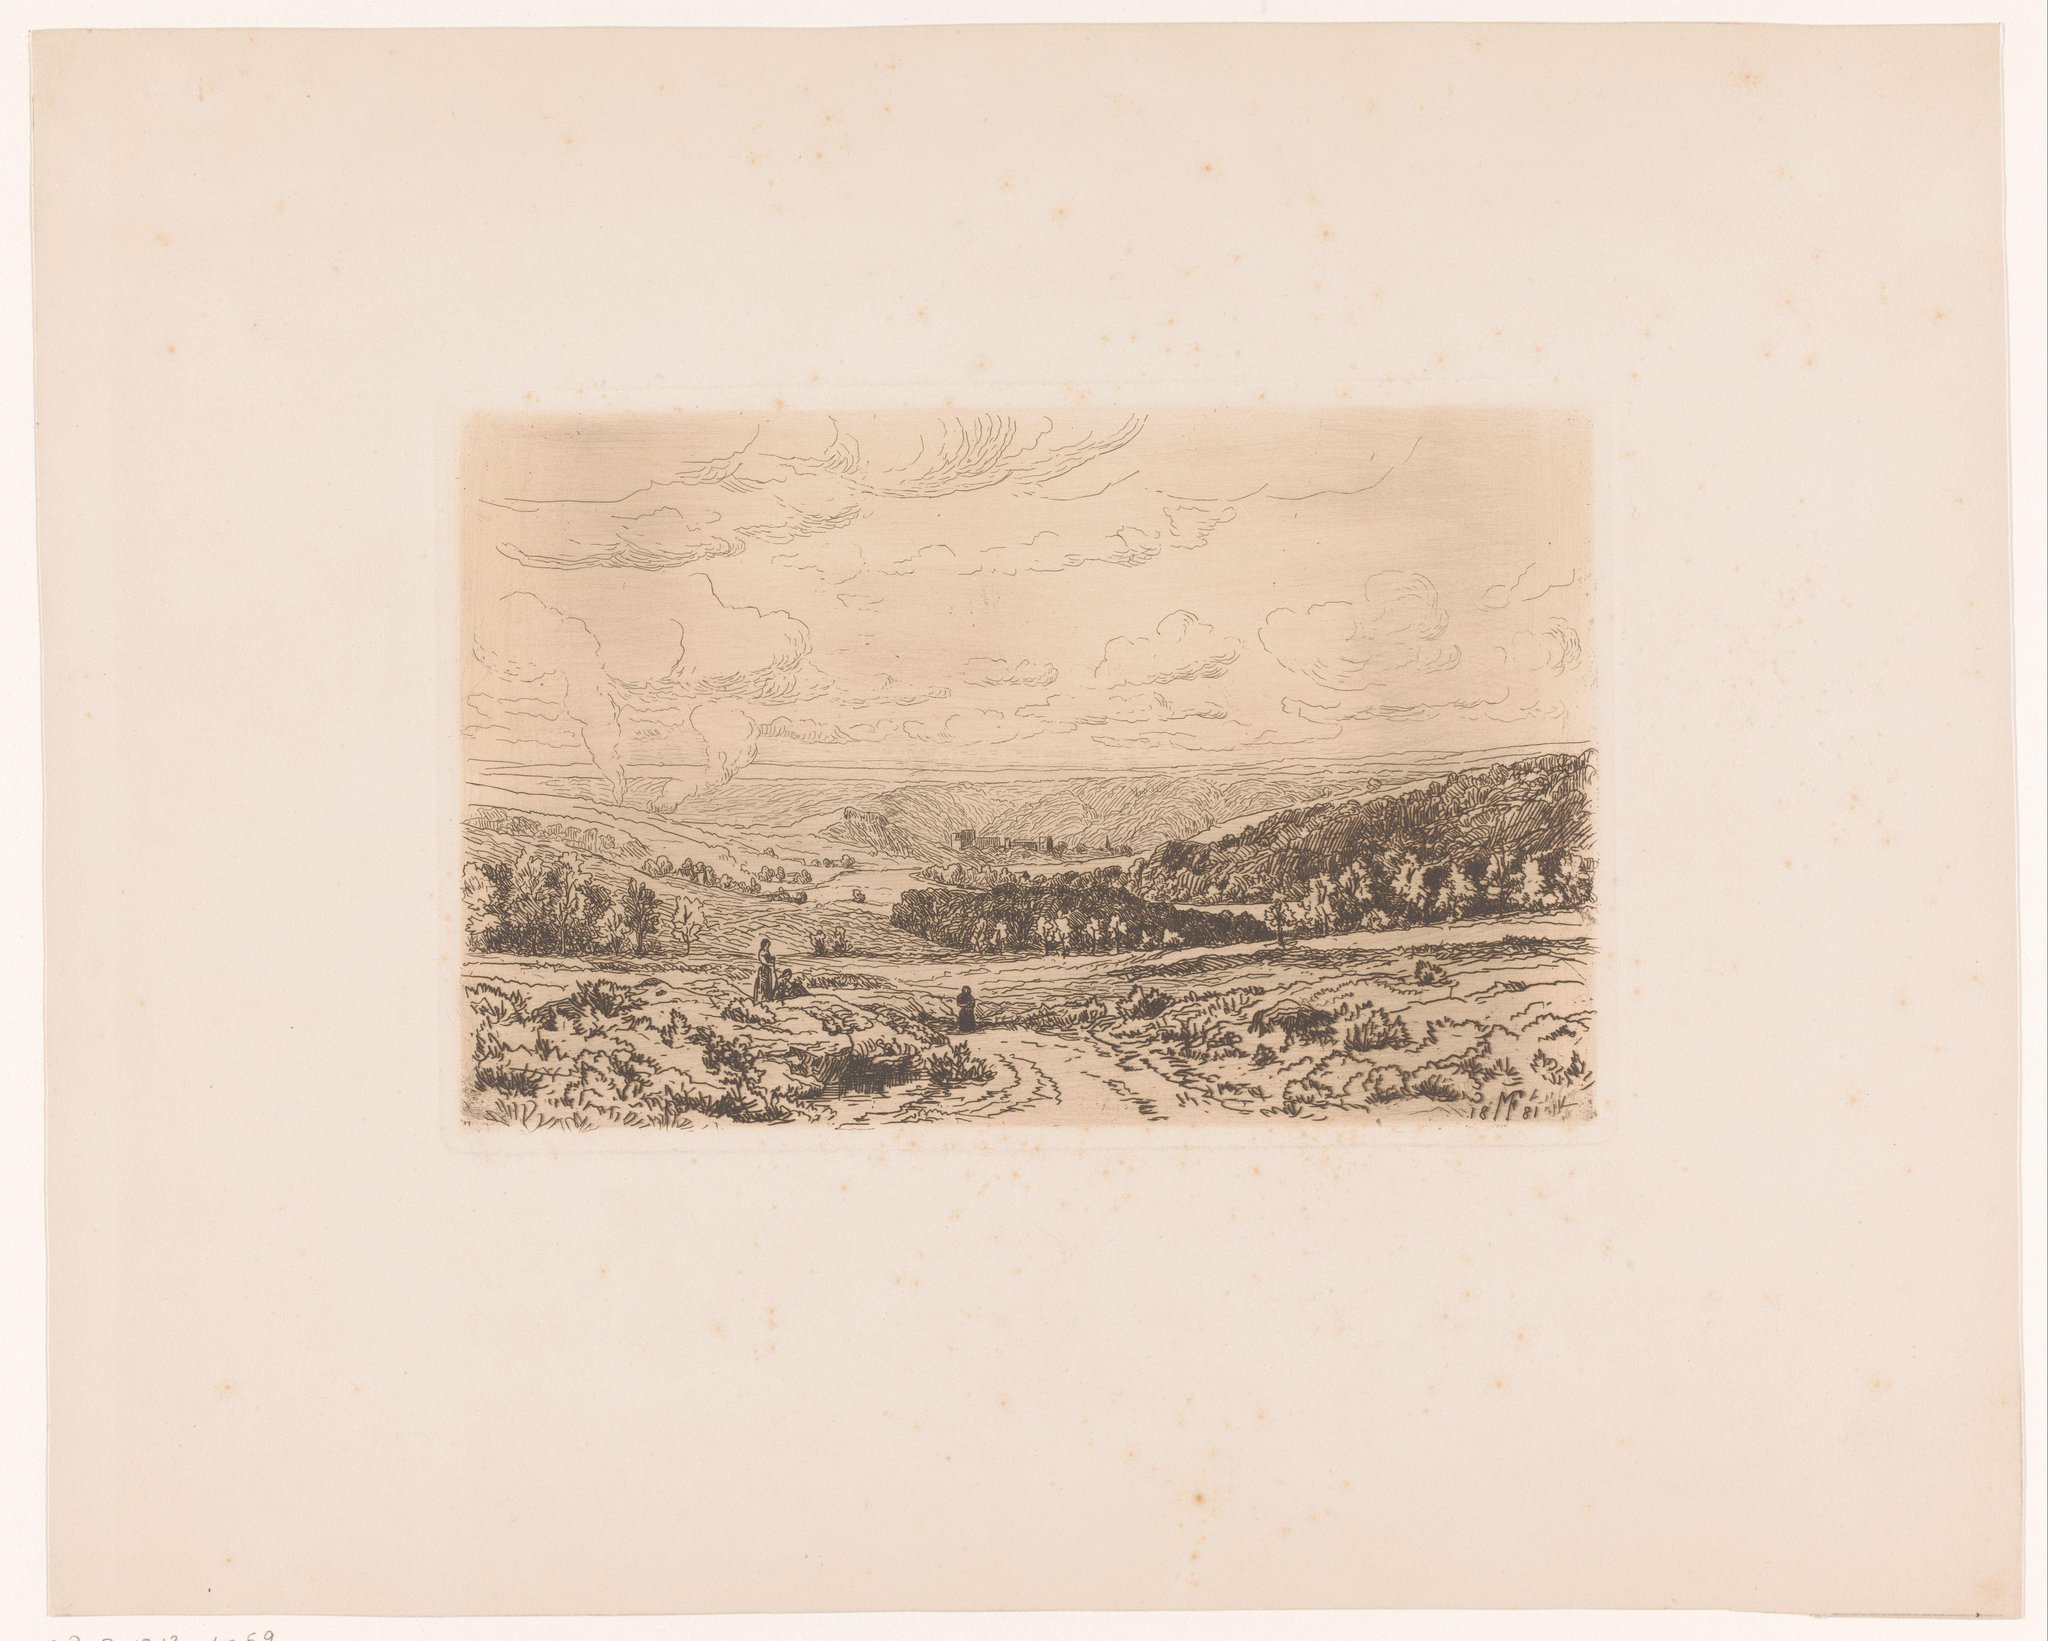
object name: print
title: Heuvellandschap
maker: maria van hohenzollern-sigmaringen (gravin van vlaanderen)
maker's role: print maker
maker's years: 1845-1912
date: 1881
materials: paper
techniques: etching, intaglio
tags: low hill country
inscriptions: collector's mark: Lugt 2228